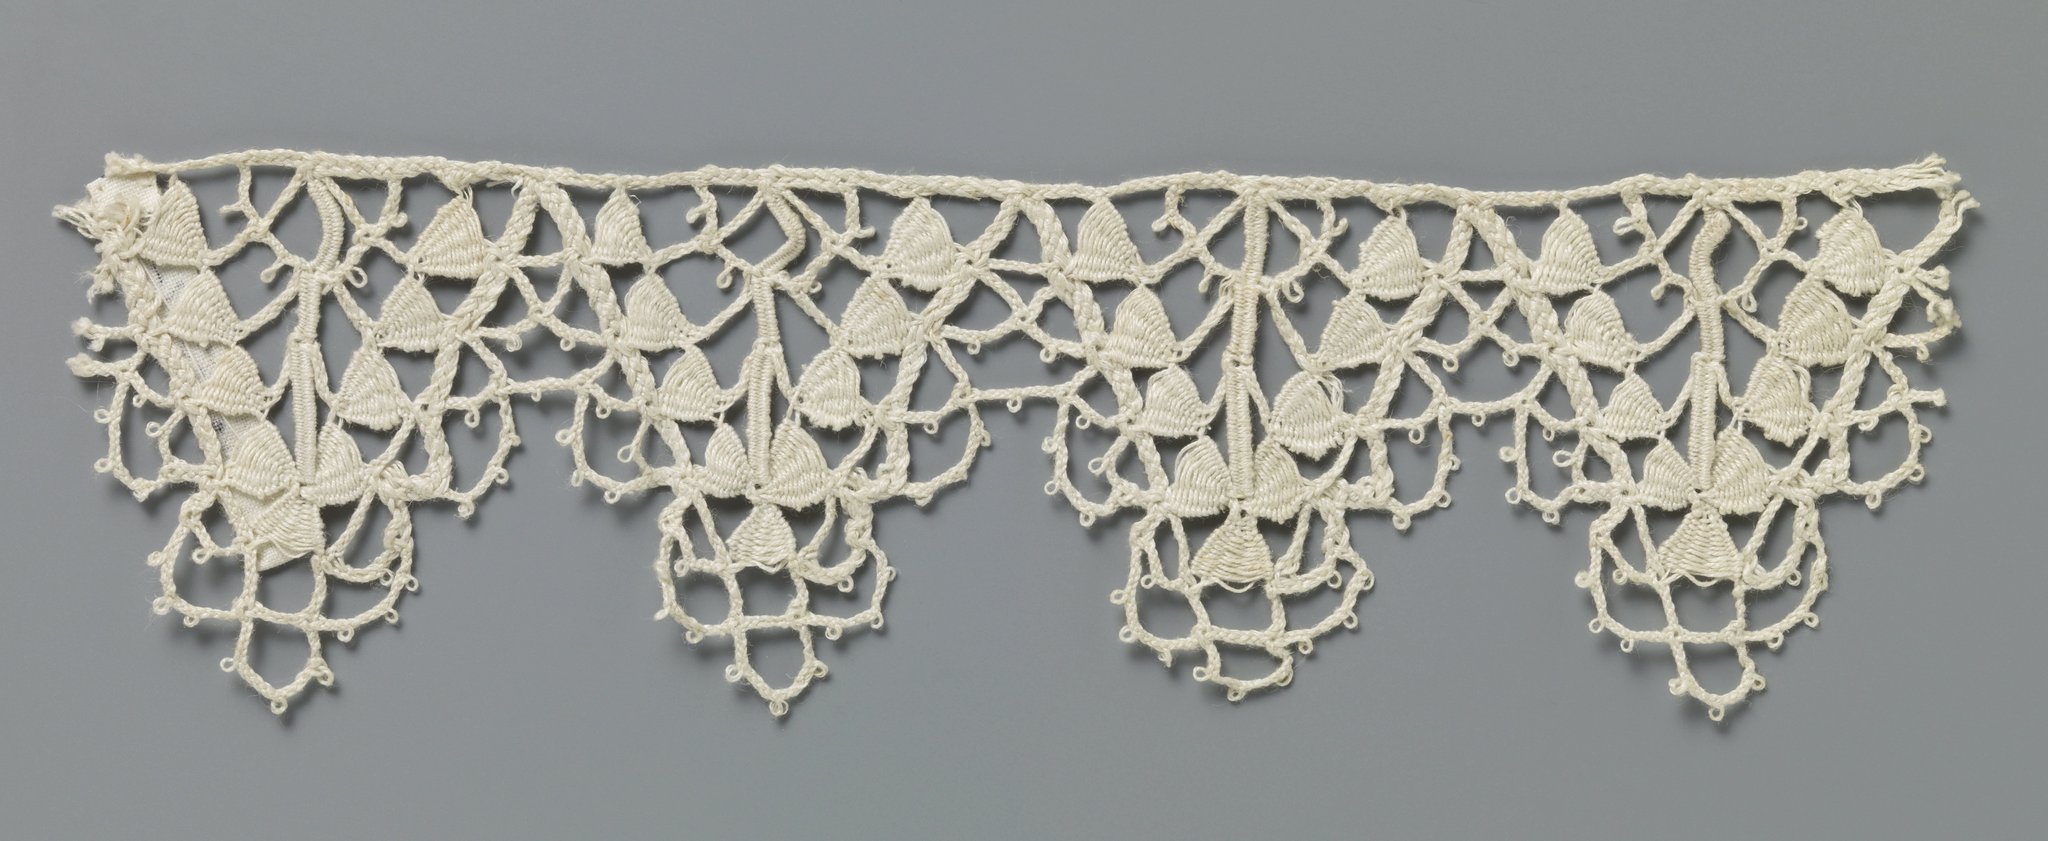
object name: strip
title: Strook met hangende driehoeken die schulpen vormen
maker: Anonymous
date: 1885-1899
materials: linen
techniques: lace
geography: volvic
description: Strook naturelkleurige kloskant. Het zich herhalende patroon bestaat uit hangende driehoeken die een schulpenrand vormen. De driehoeken bestaan uit een vertikale middenlijn gemaakt in vormslag met twee ribben. Met vlechtjes zijn hieraan trechtervormige motiefjes verbonden, die van onder naar boven langs de middenlijn zijn opgestapeld en de twee lange zijden van elke driehoek vormen. De trechtervormige motiefjes zijn gemaakt in vormslag met vijf ribben. De buitenkant van elke driehoek is afgewerkt met een dubbel rij boogjes, gemaakt met gepicoteerde vlechtjes. De bovenzijde van de strook is recht afgewerkt.